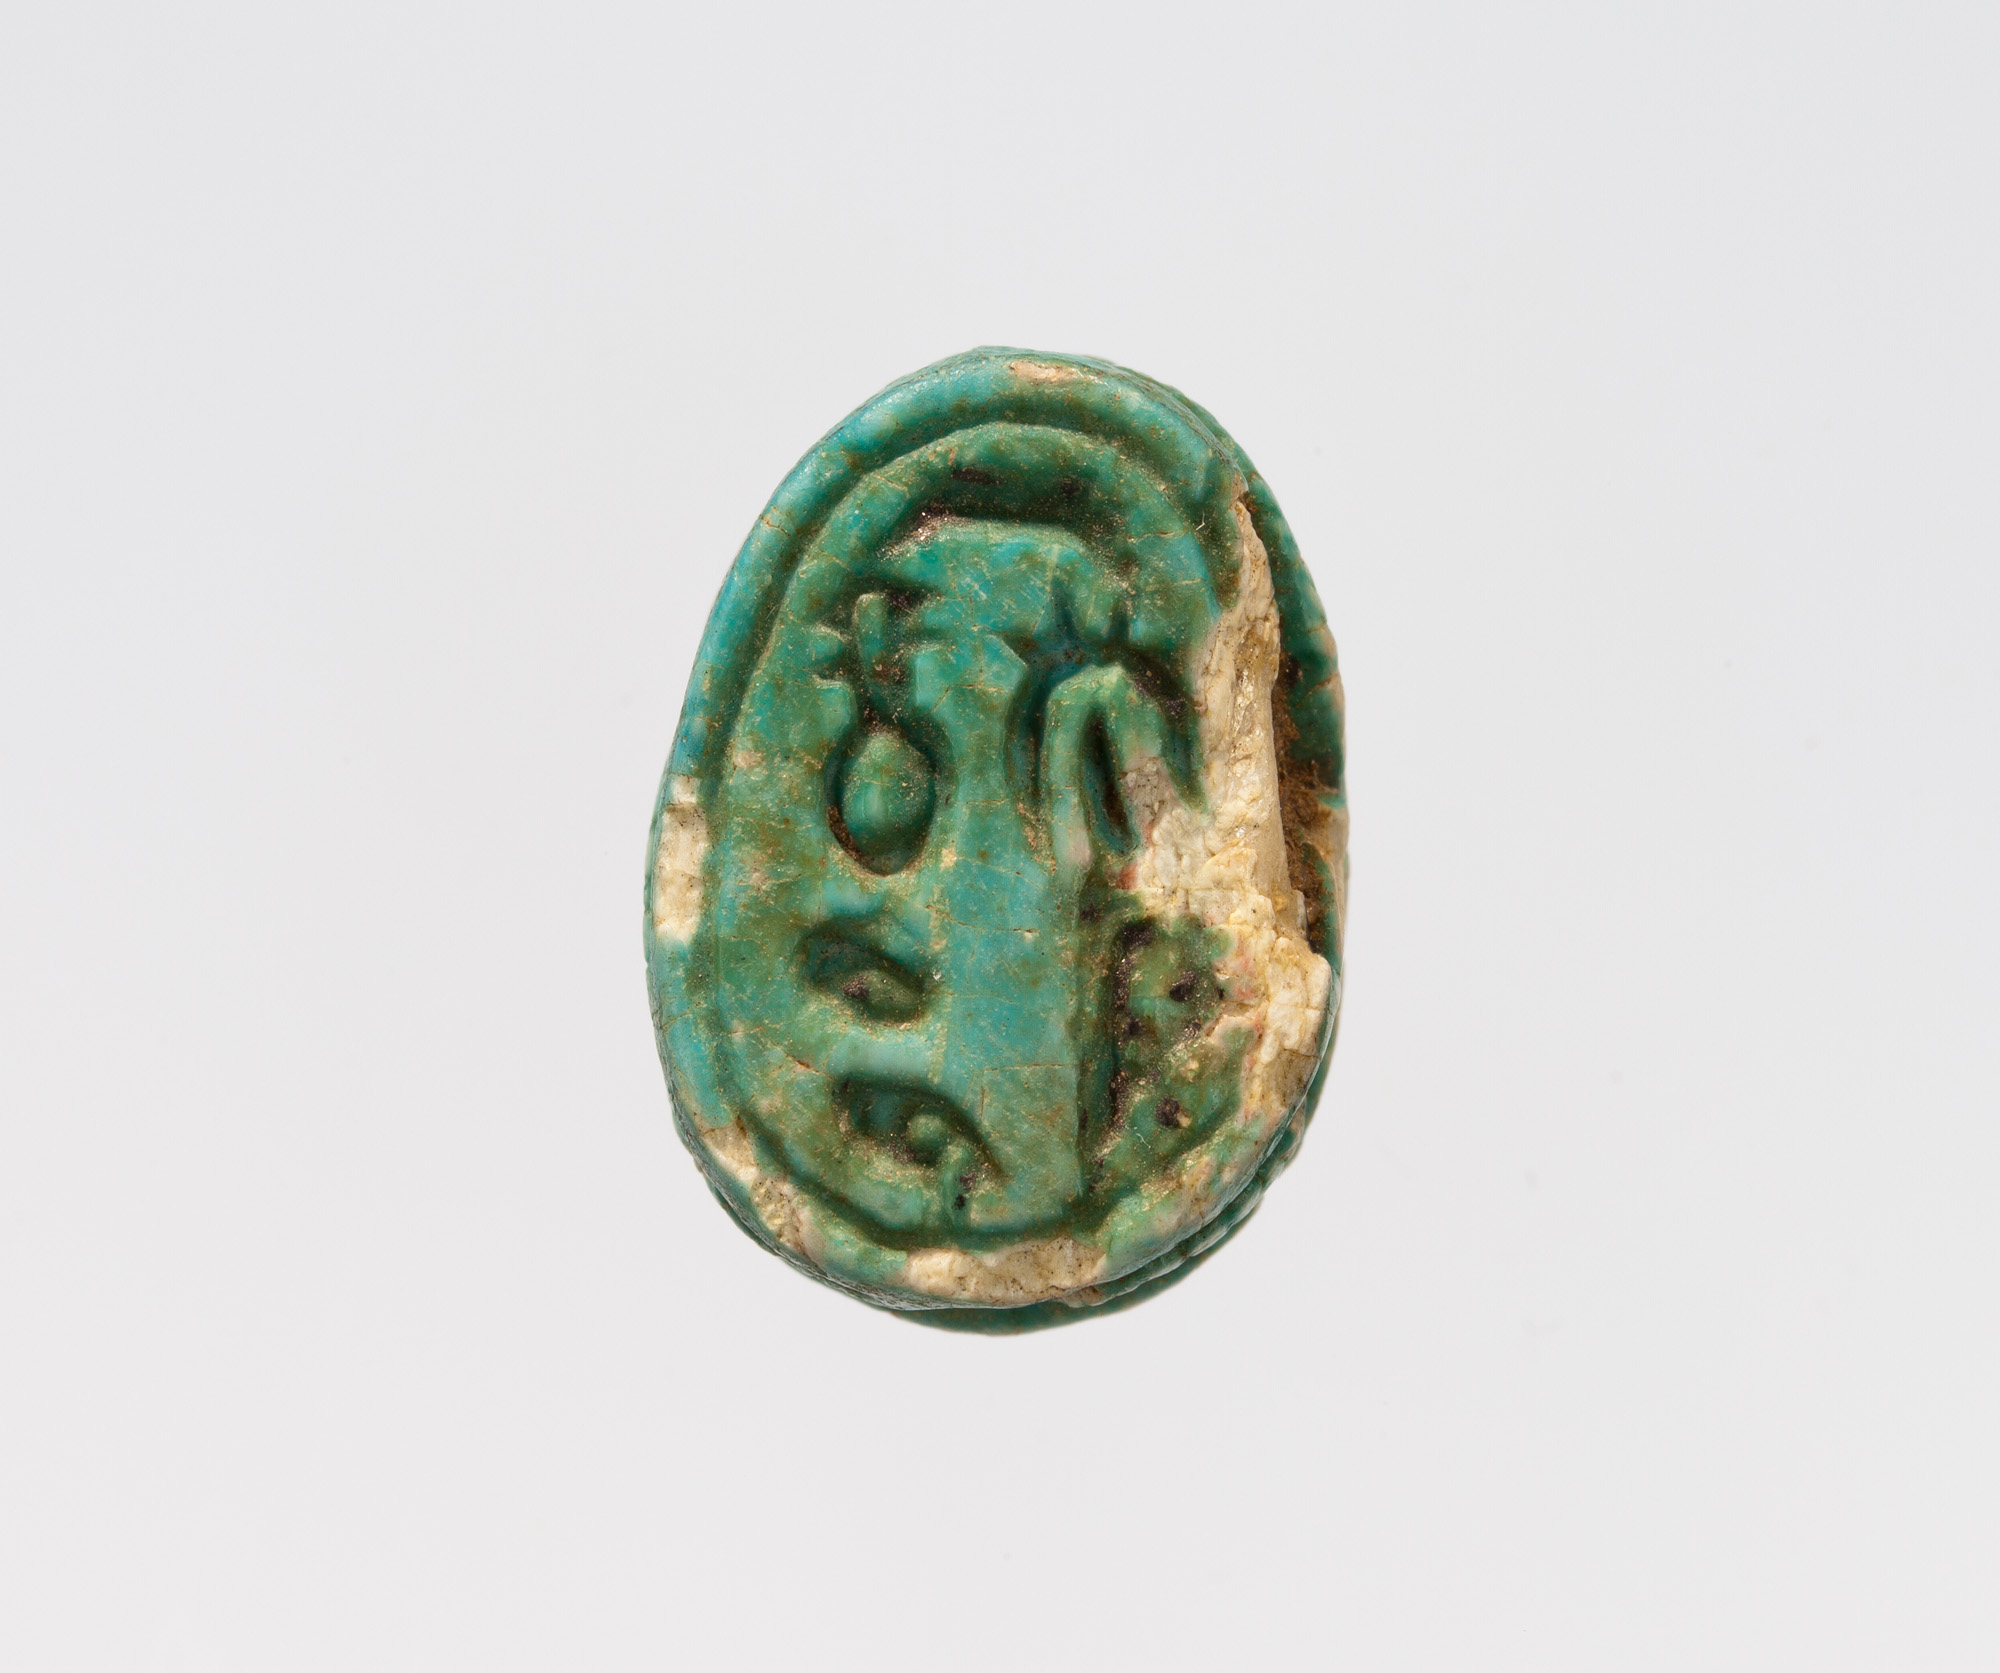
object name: scarab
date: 1479-1458 BCE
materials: faience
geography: egypt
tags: hieroglyphs,scarabs